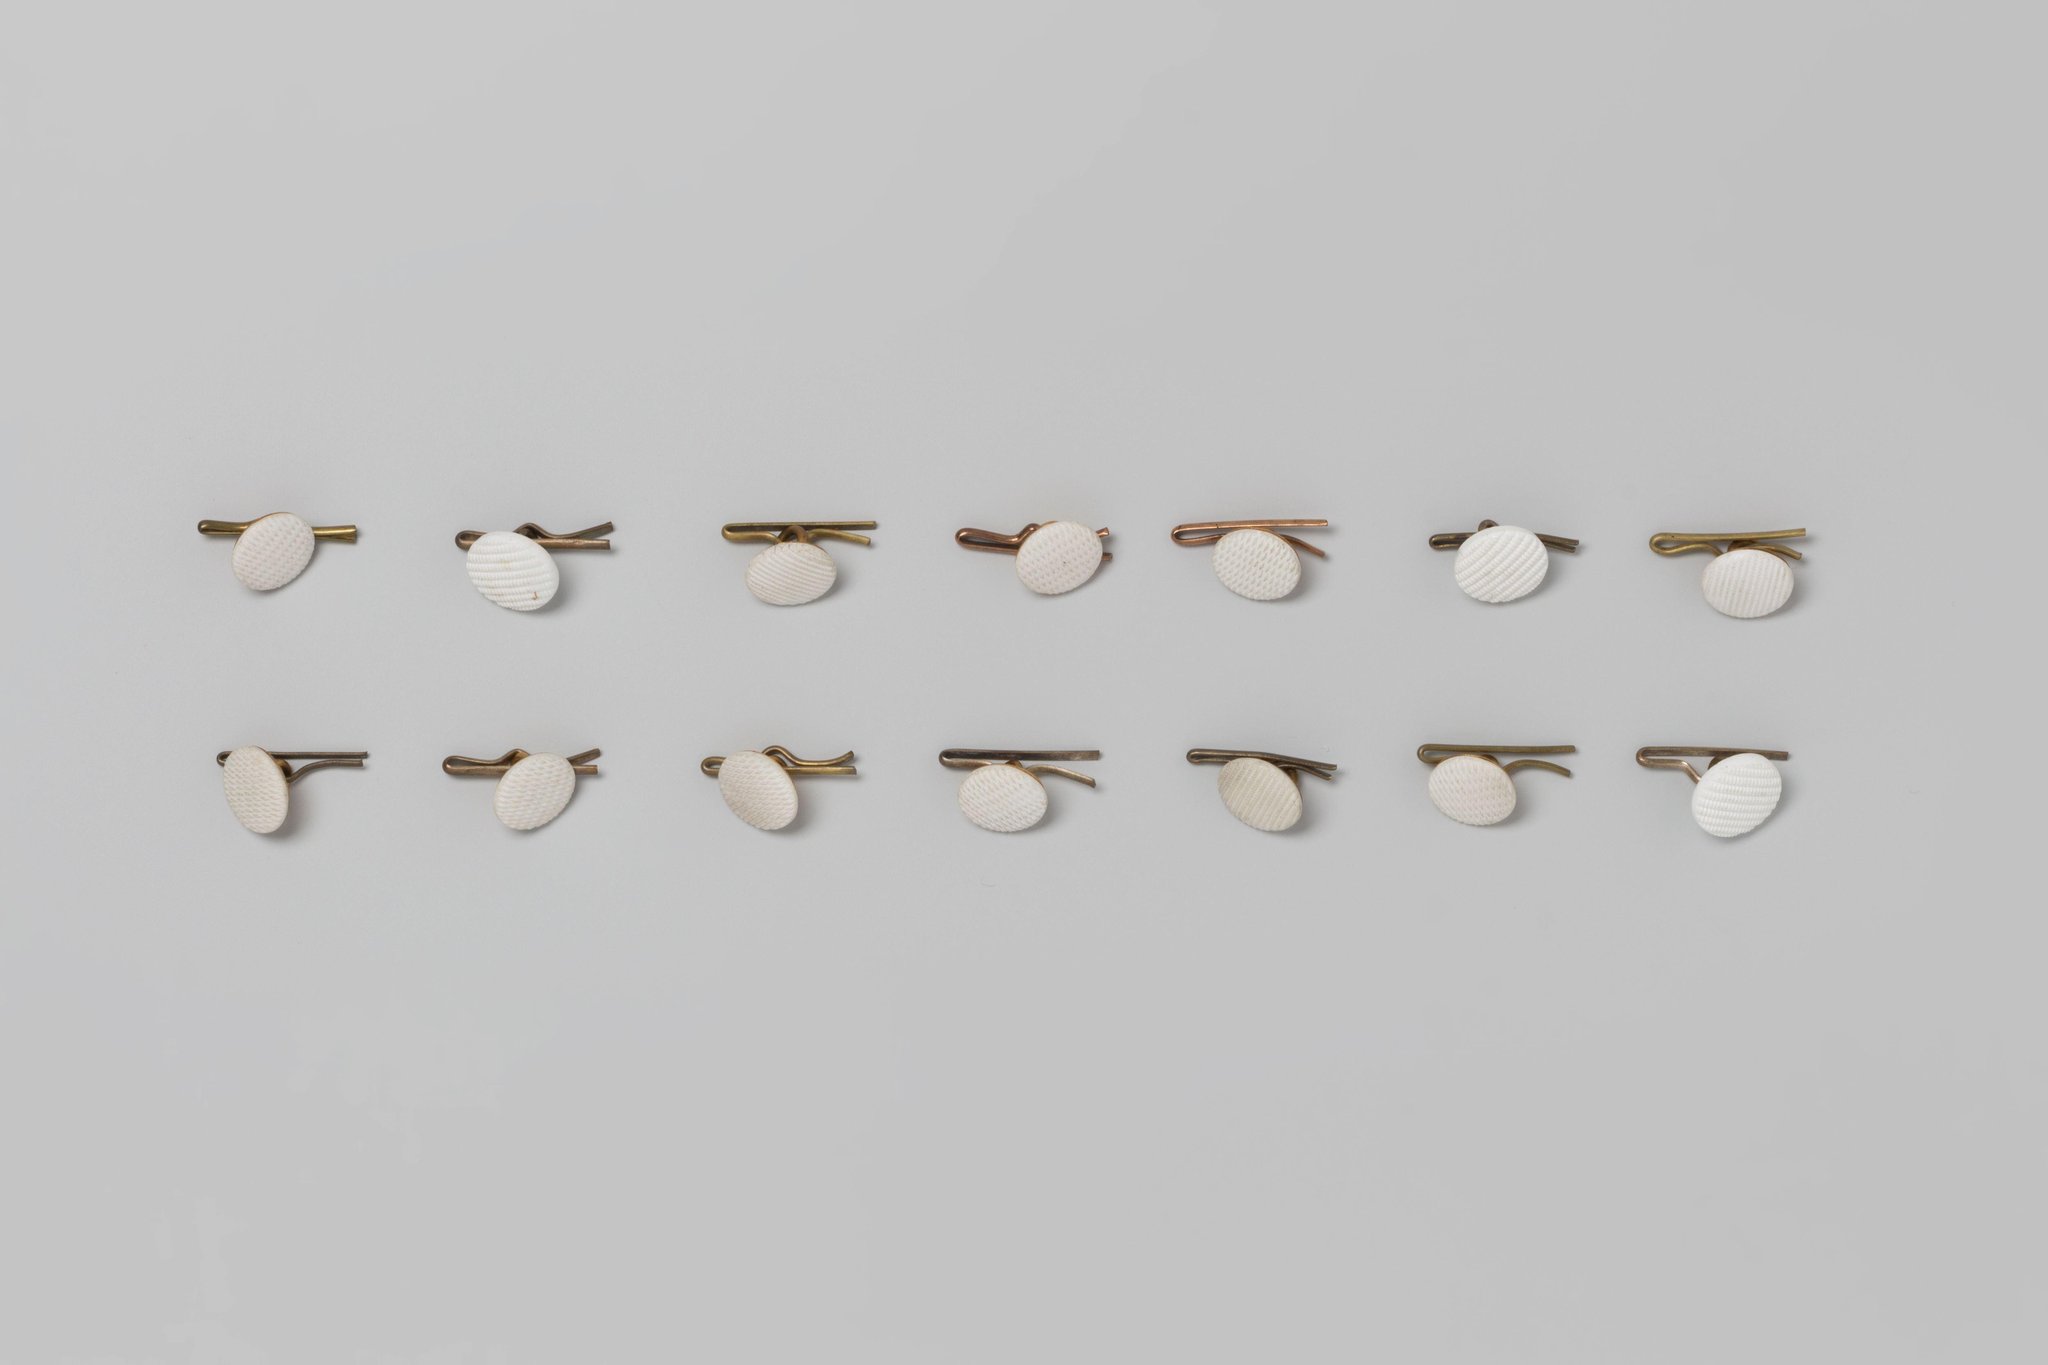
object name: vestknoop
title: Vestknoop van kunststof met reliëf-ribbel, vast oogje en losse tegenklem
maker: Anonymous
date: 1900-1940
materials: copper, plastic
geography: netherlands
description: Vestknoop van kunststof met reliëf-ribbel, vast oogje en losse tegenklem.